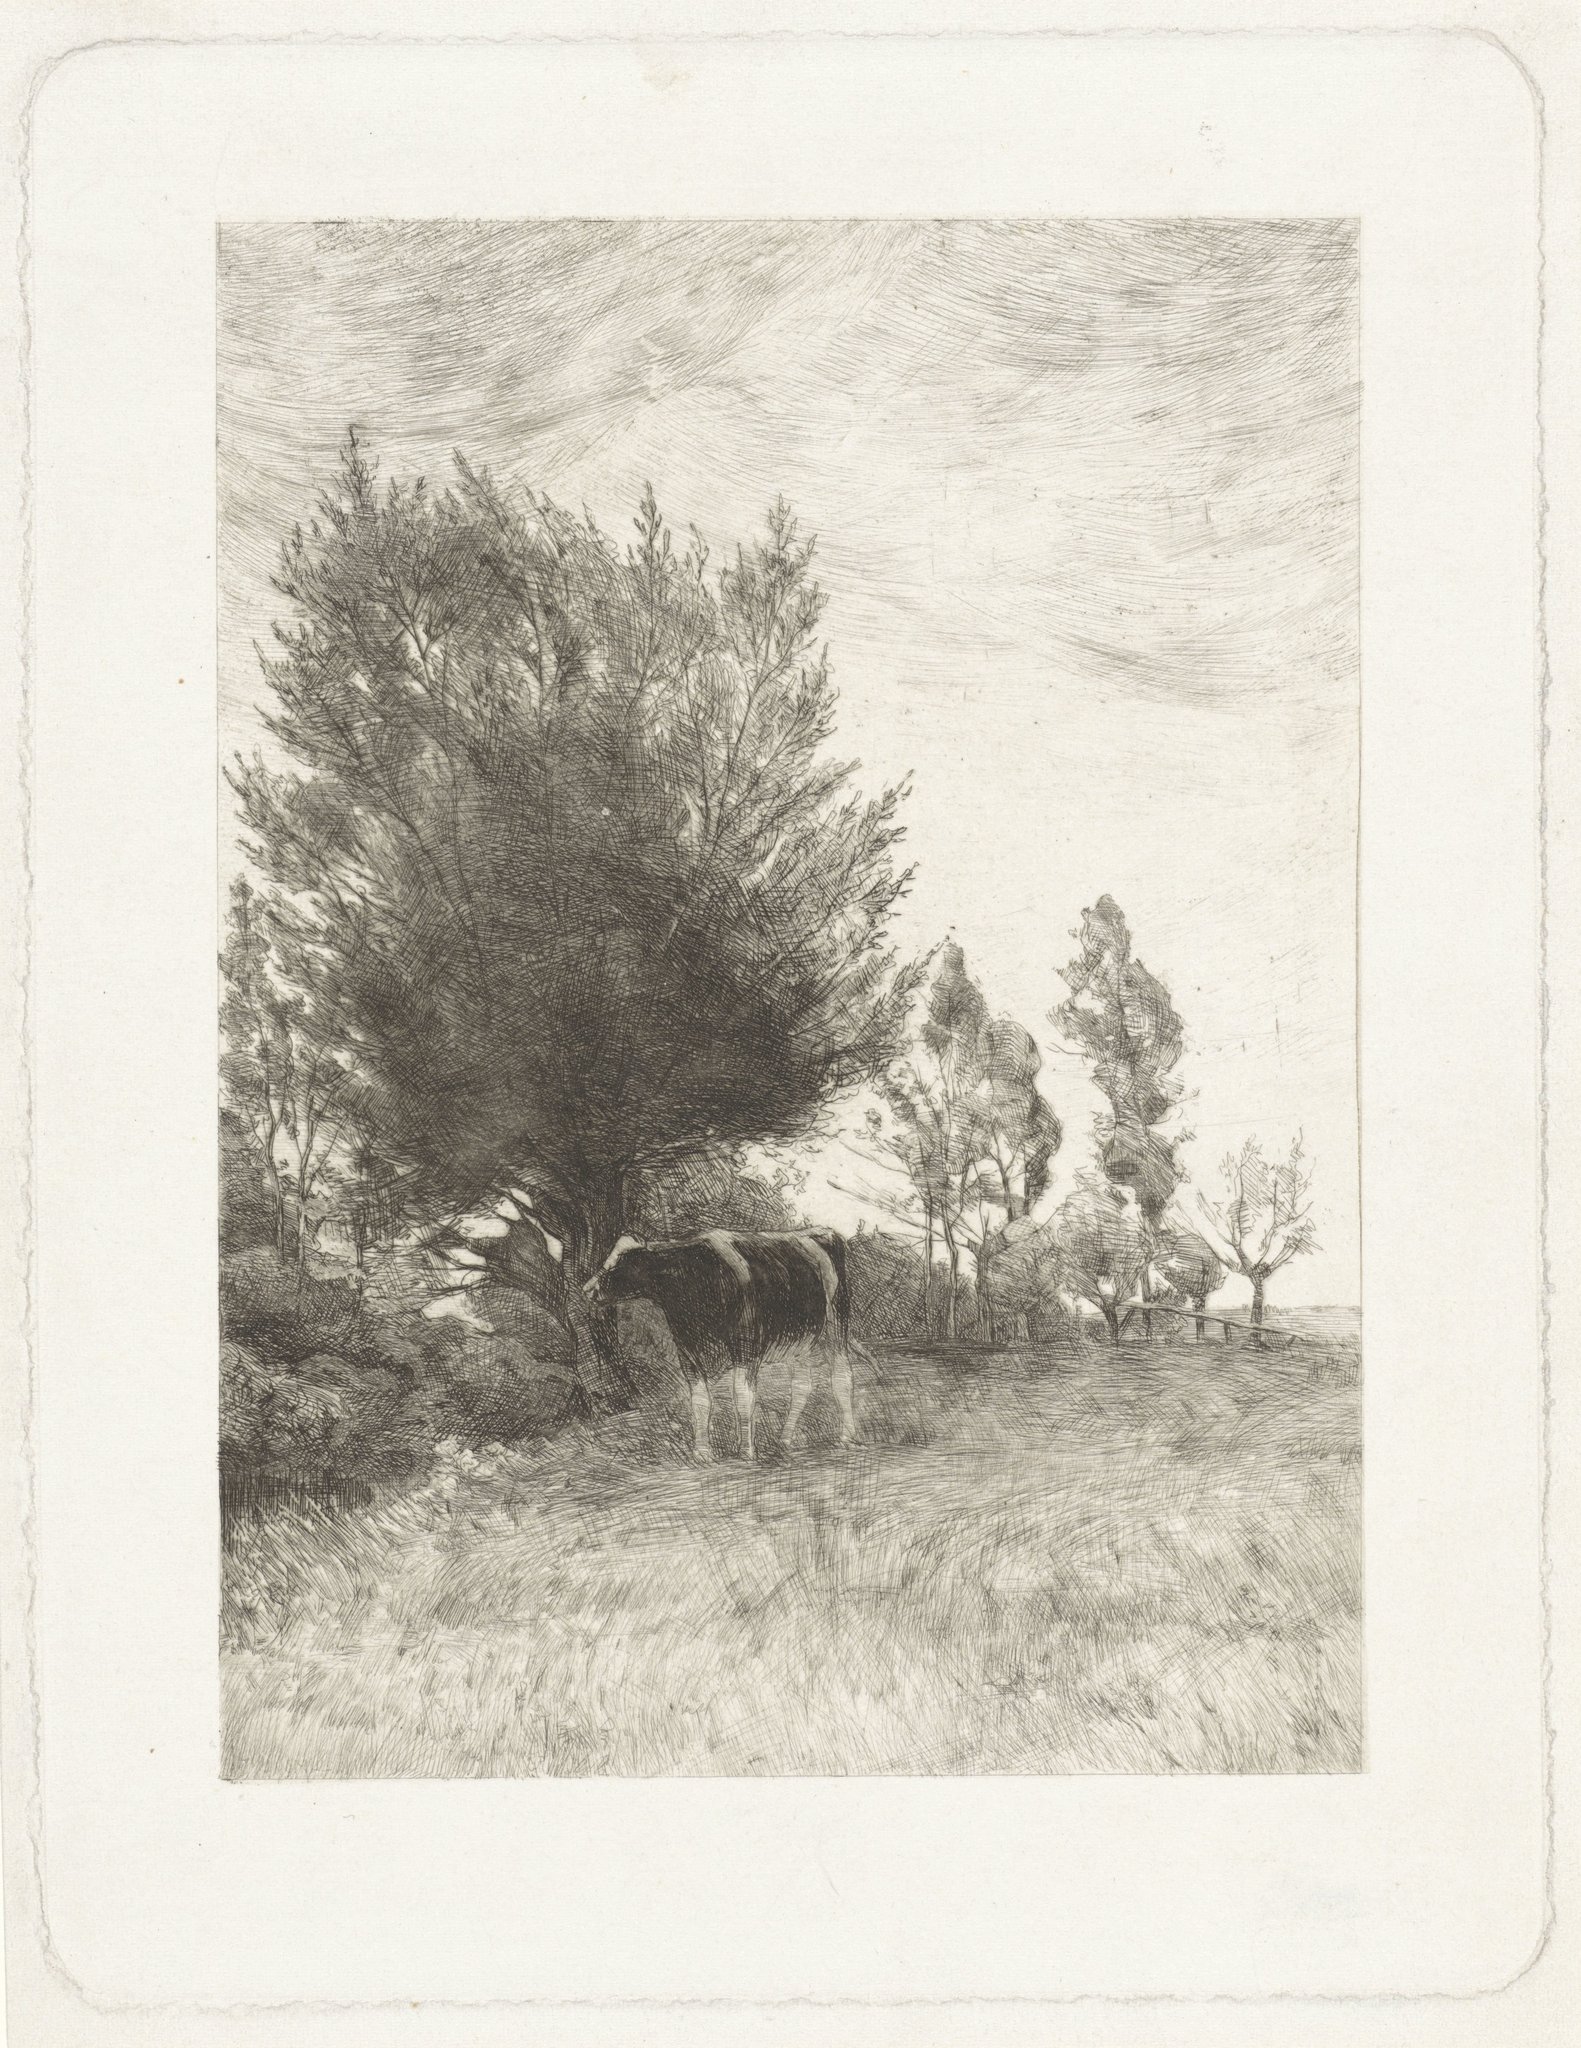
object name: print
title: Landschap met koe bij boom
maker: willem steelink (ii)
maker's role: draughtsman, print maker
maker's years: 1856-1928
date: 1866-1903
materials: paper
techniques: etching, intaglio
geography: netherlands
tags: cow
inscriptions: collector's mark: Lugt 2228